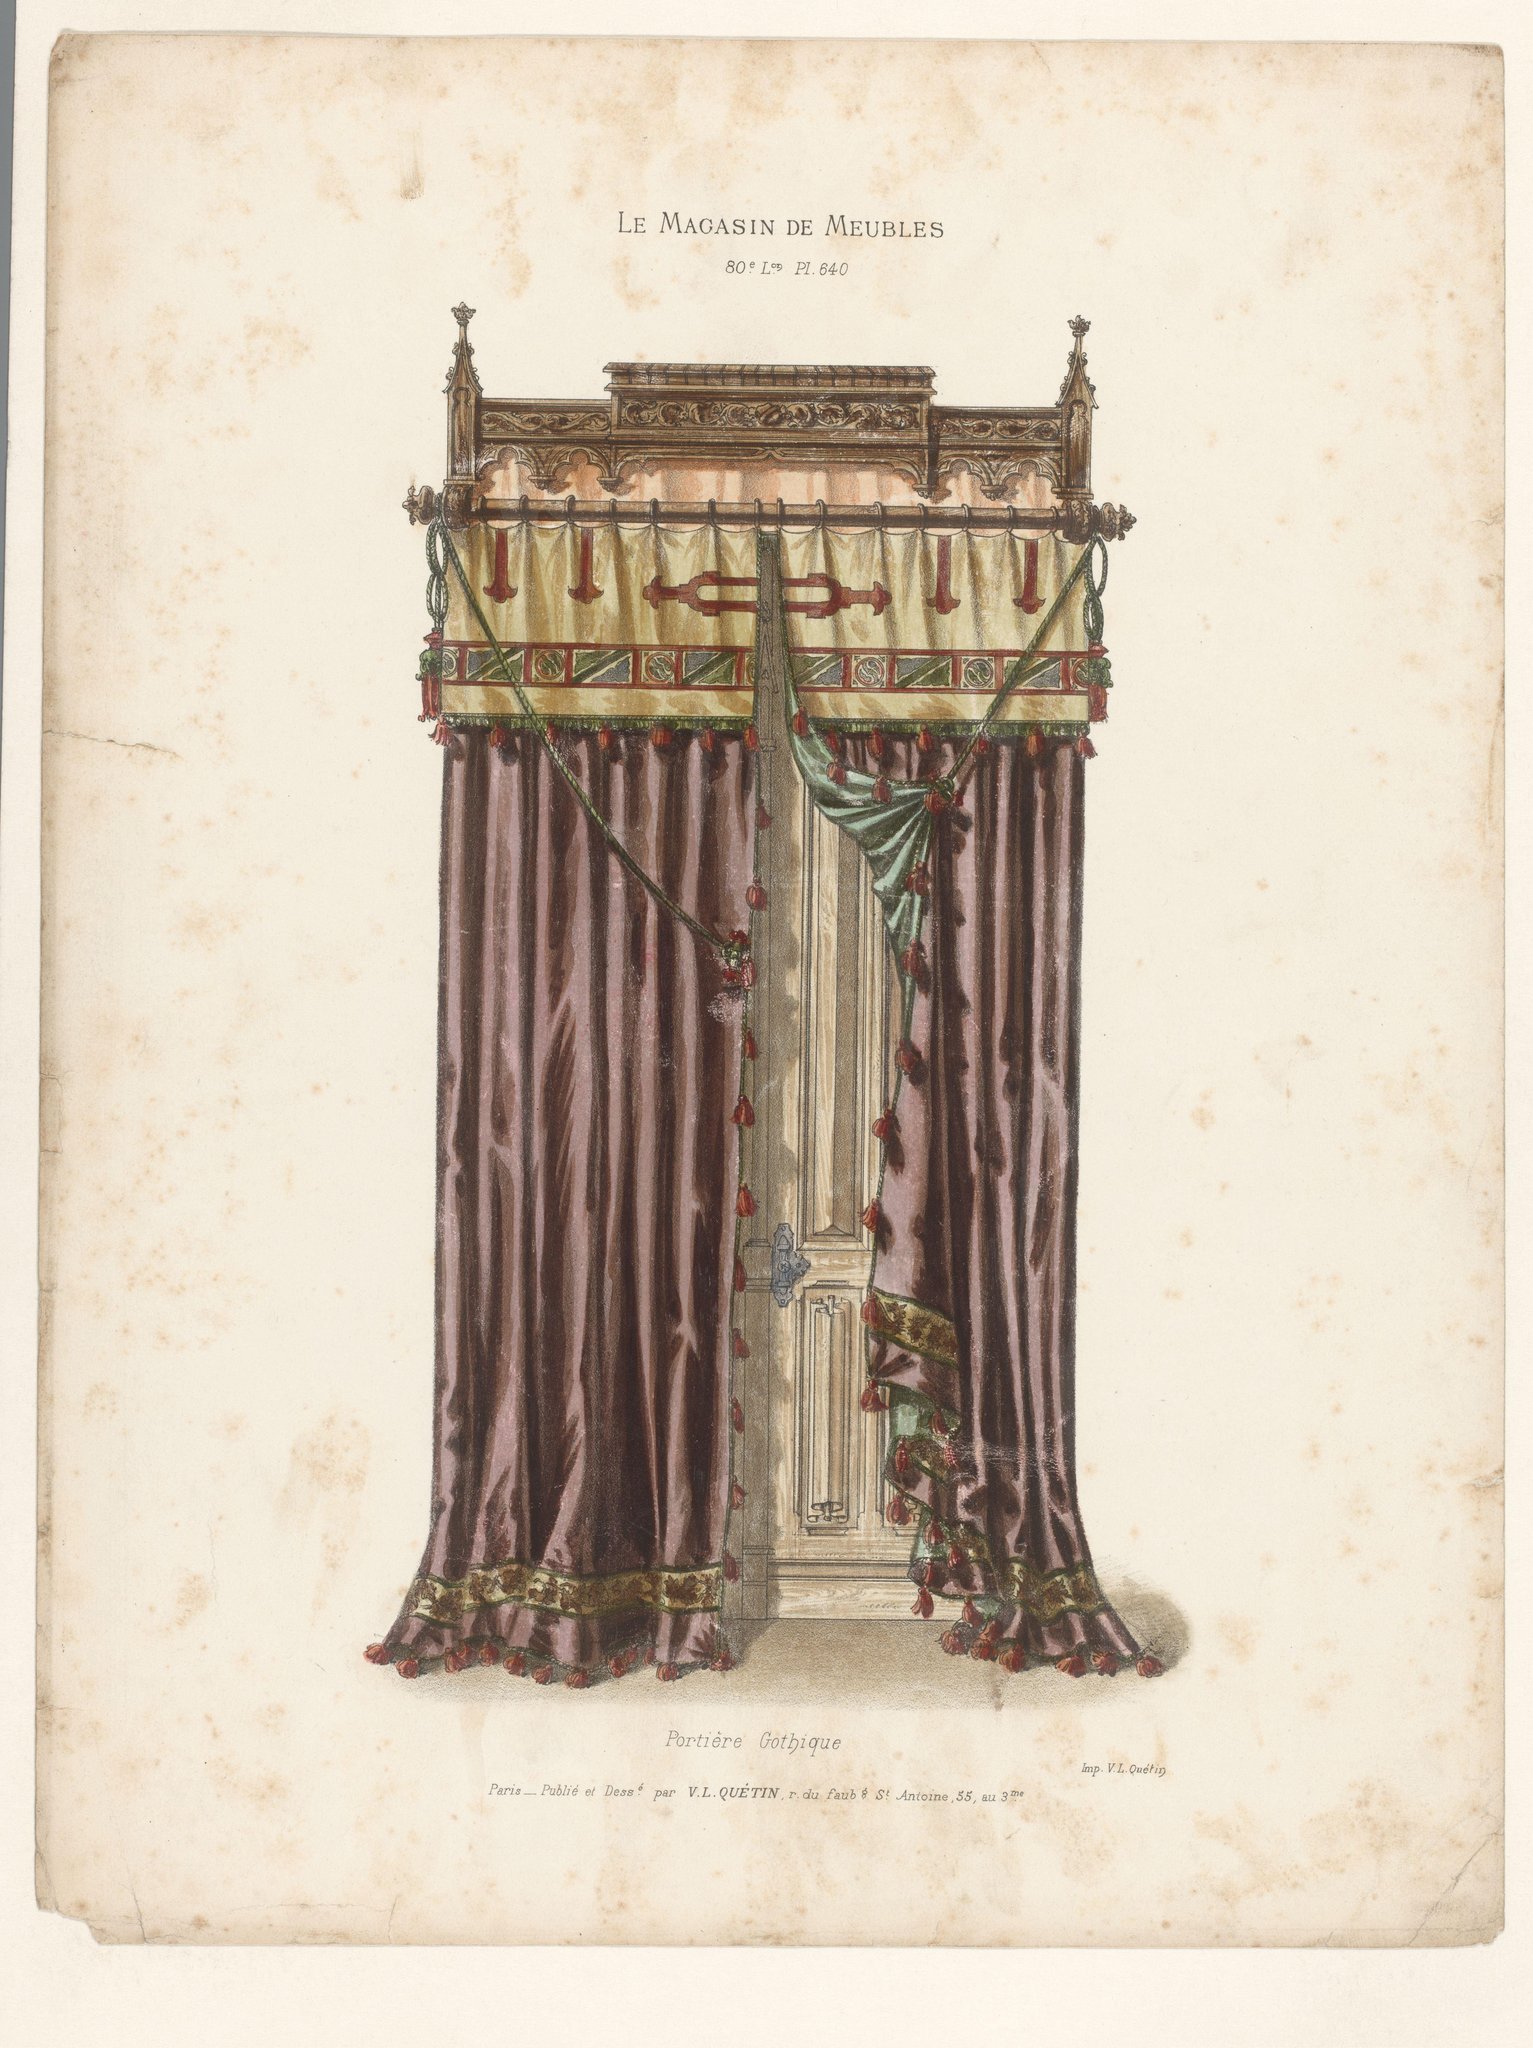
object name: print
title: Venster met gordijnen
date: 1878-1904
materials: paper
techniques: hand coloring, lithograph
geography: paris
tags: window, hangings and drapery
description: Een gotisch venster met gedrapeerde gordijnen. Prent uit 80e Livraison.